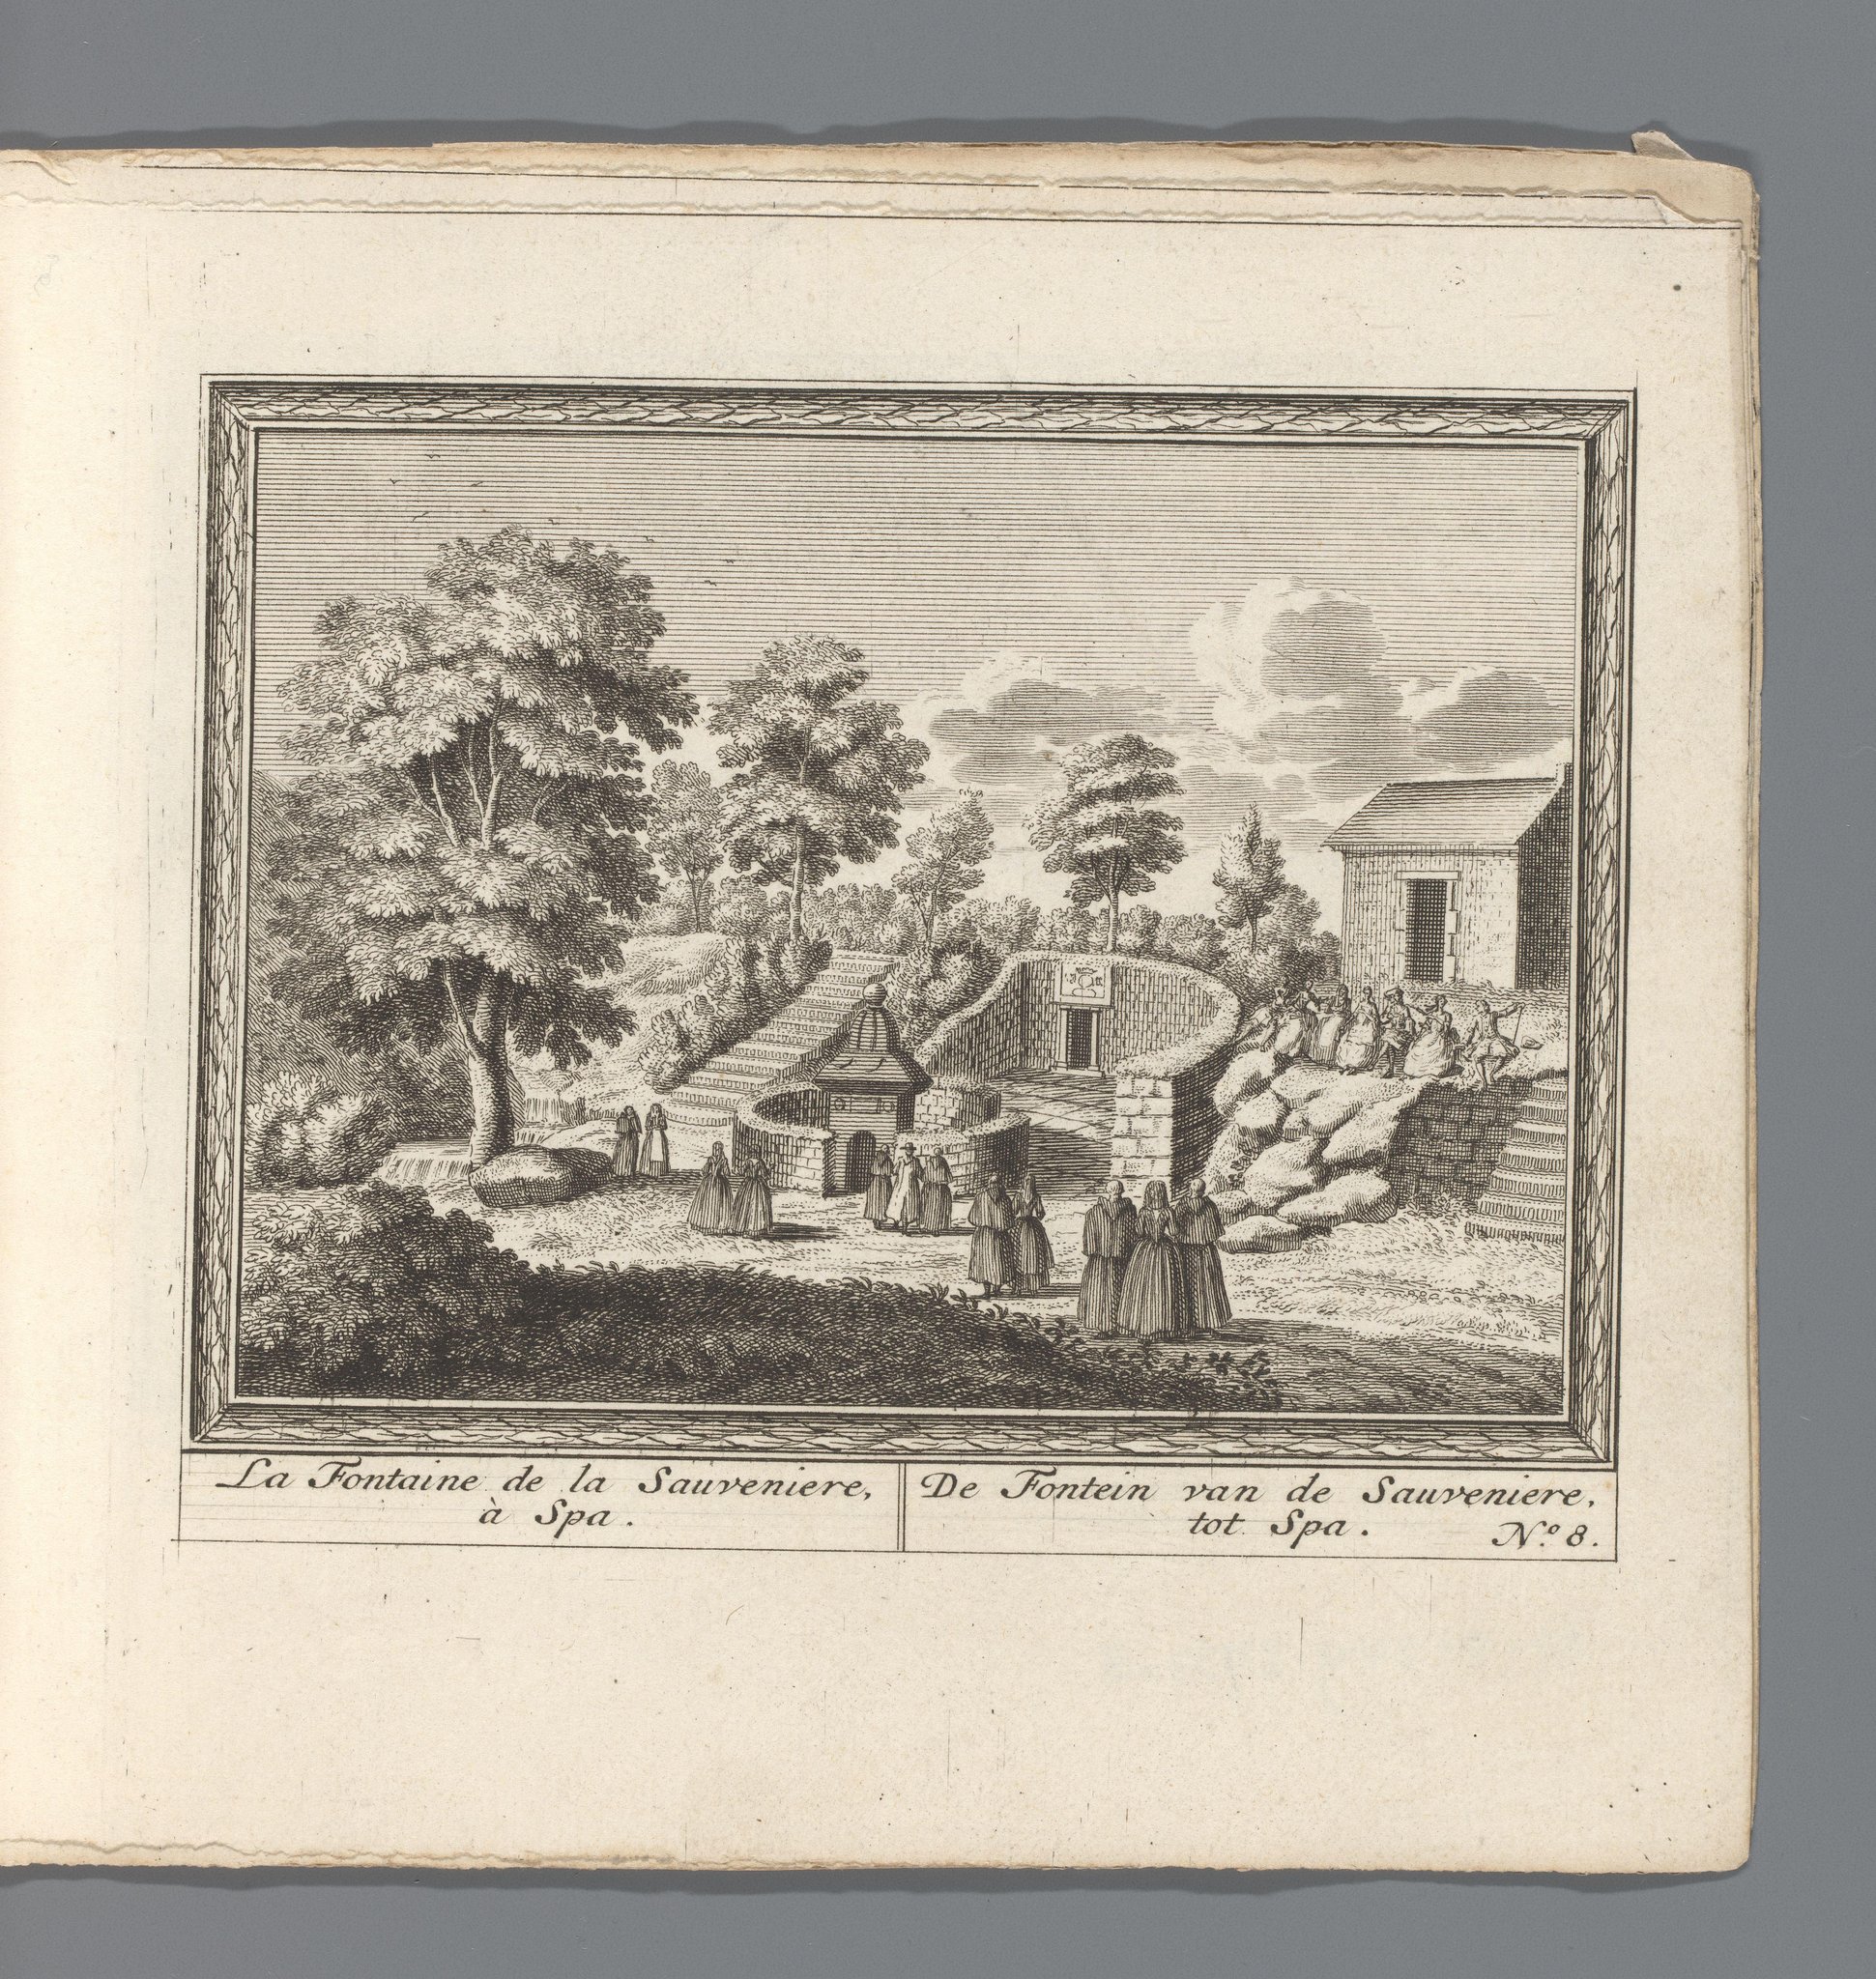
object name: book illustration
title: La fontaine de la Sauveniere, à Spa / De fontein van de Sauveniere, tot Spa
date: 1734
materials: paper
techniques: etching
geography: amsterdam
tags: city-view in general; 'veduta', mineral water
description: Deze serie prenten is gebruikt in: Pöllnitz, Charles-Louis. Amuseums des eaux de Spa. Ouvrage utile a ceux qui vont boire ces eaux minérales sur les lieux. 2 dln. Amsterdam: Pieter Mortier, 1734. In deze uitgave zijn de prenten echter gevouwen. Mogelijk is deze serie een losse uitgave van de prenten. Er ontbreekt één prent die in het boek is opgenomen (nr. 4), waarop geen landschap is afgebeeld.